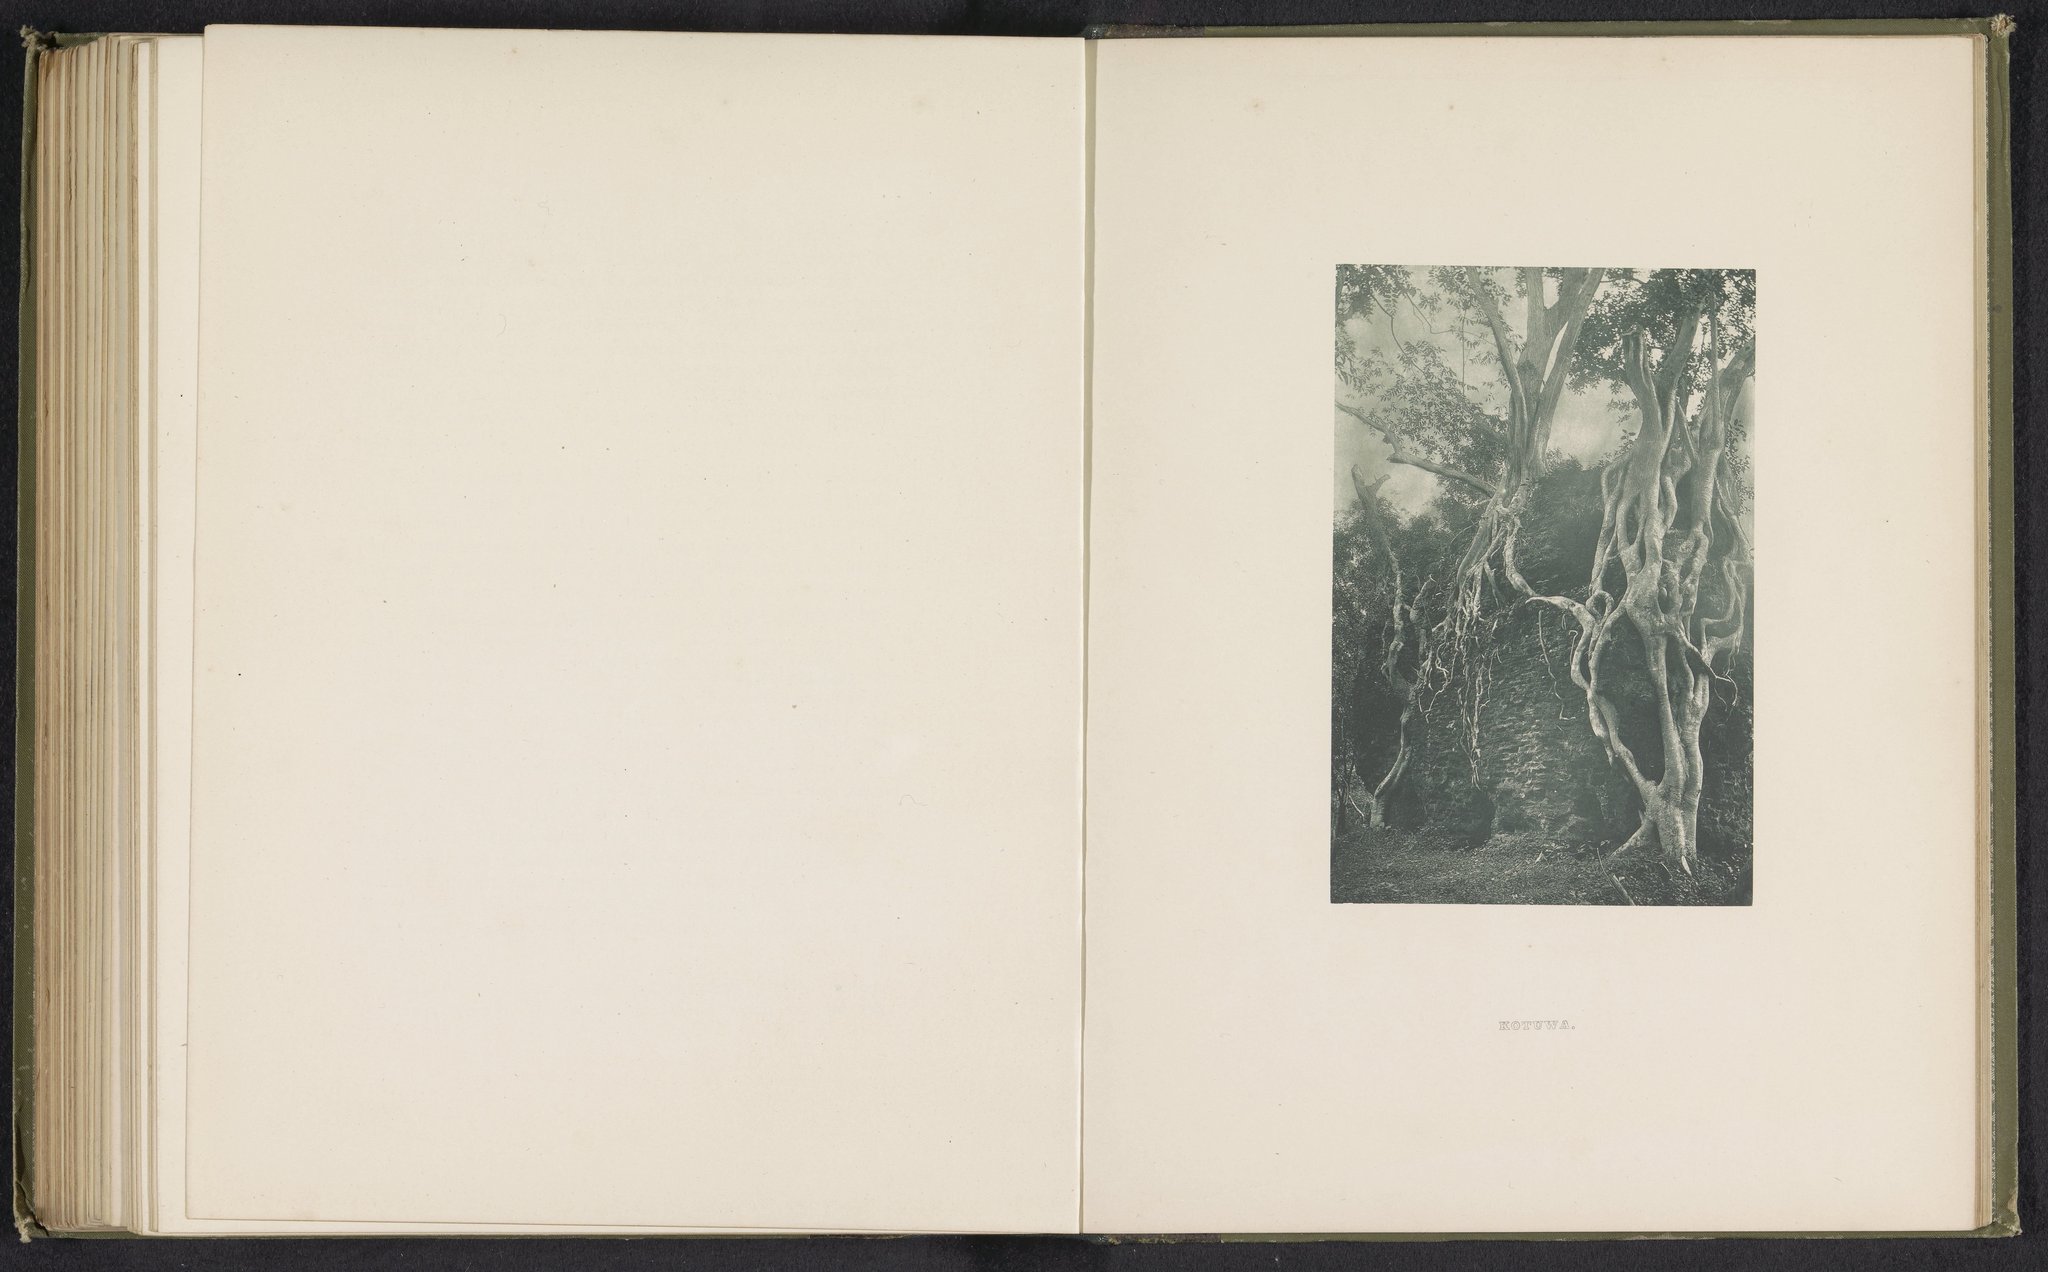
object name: photomechanical print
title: Ruins of a fort at Polonnaruwa, Sri Lanka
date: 1896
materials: paper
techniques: woodburygravure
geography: polonnaruwa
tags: fortress, ruin of a building ~ architecture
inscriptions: title: ‘KOTUWA.’